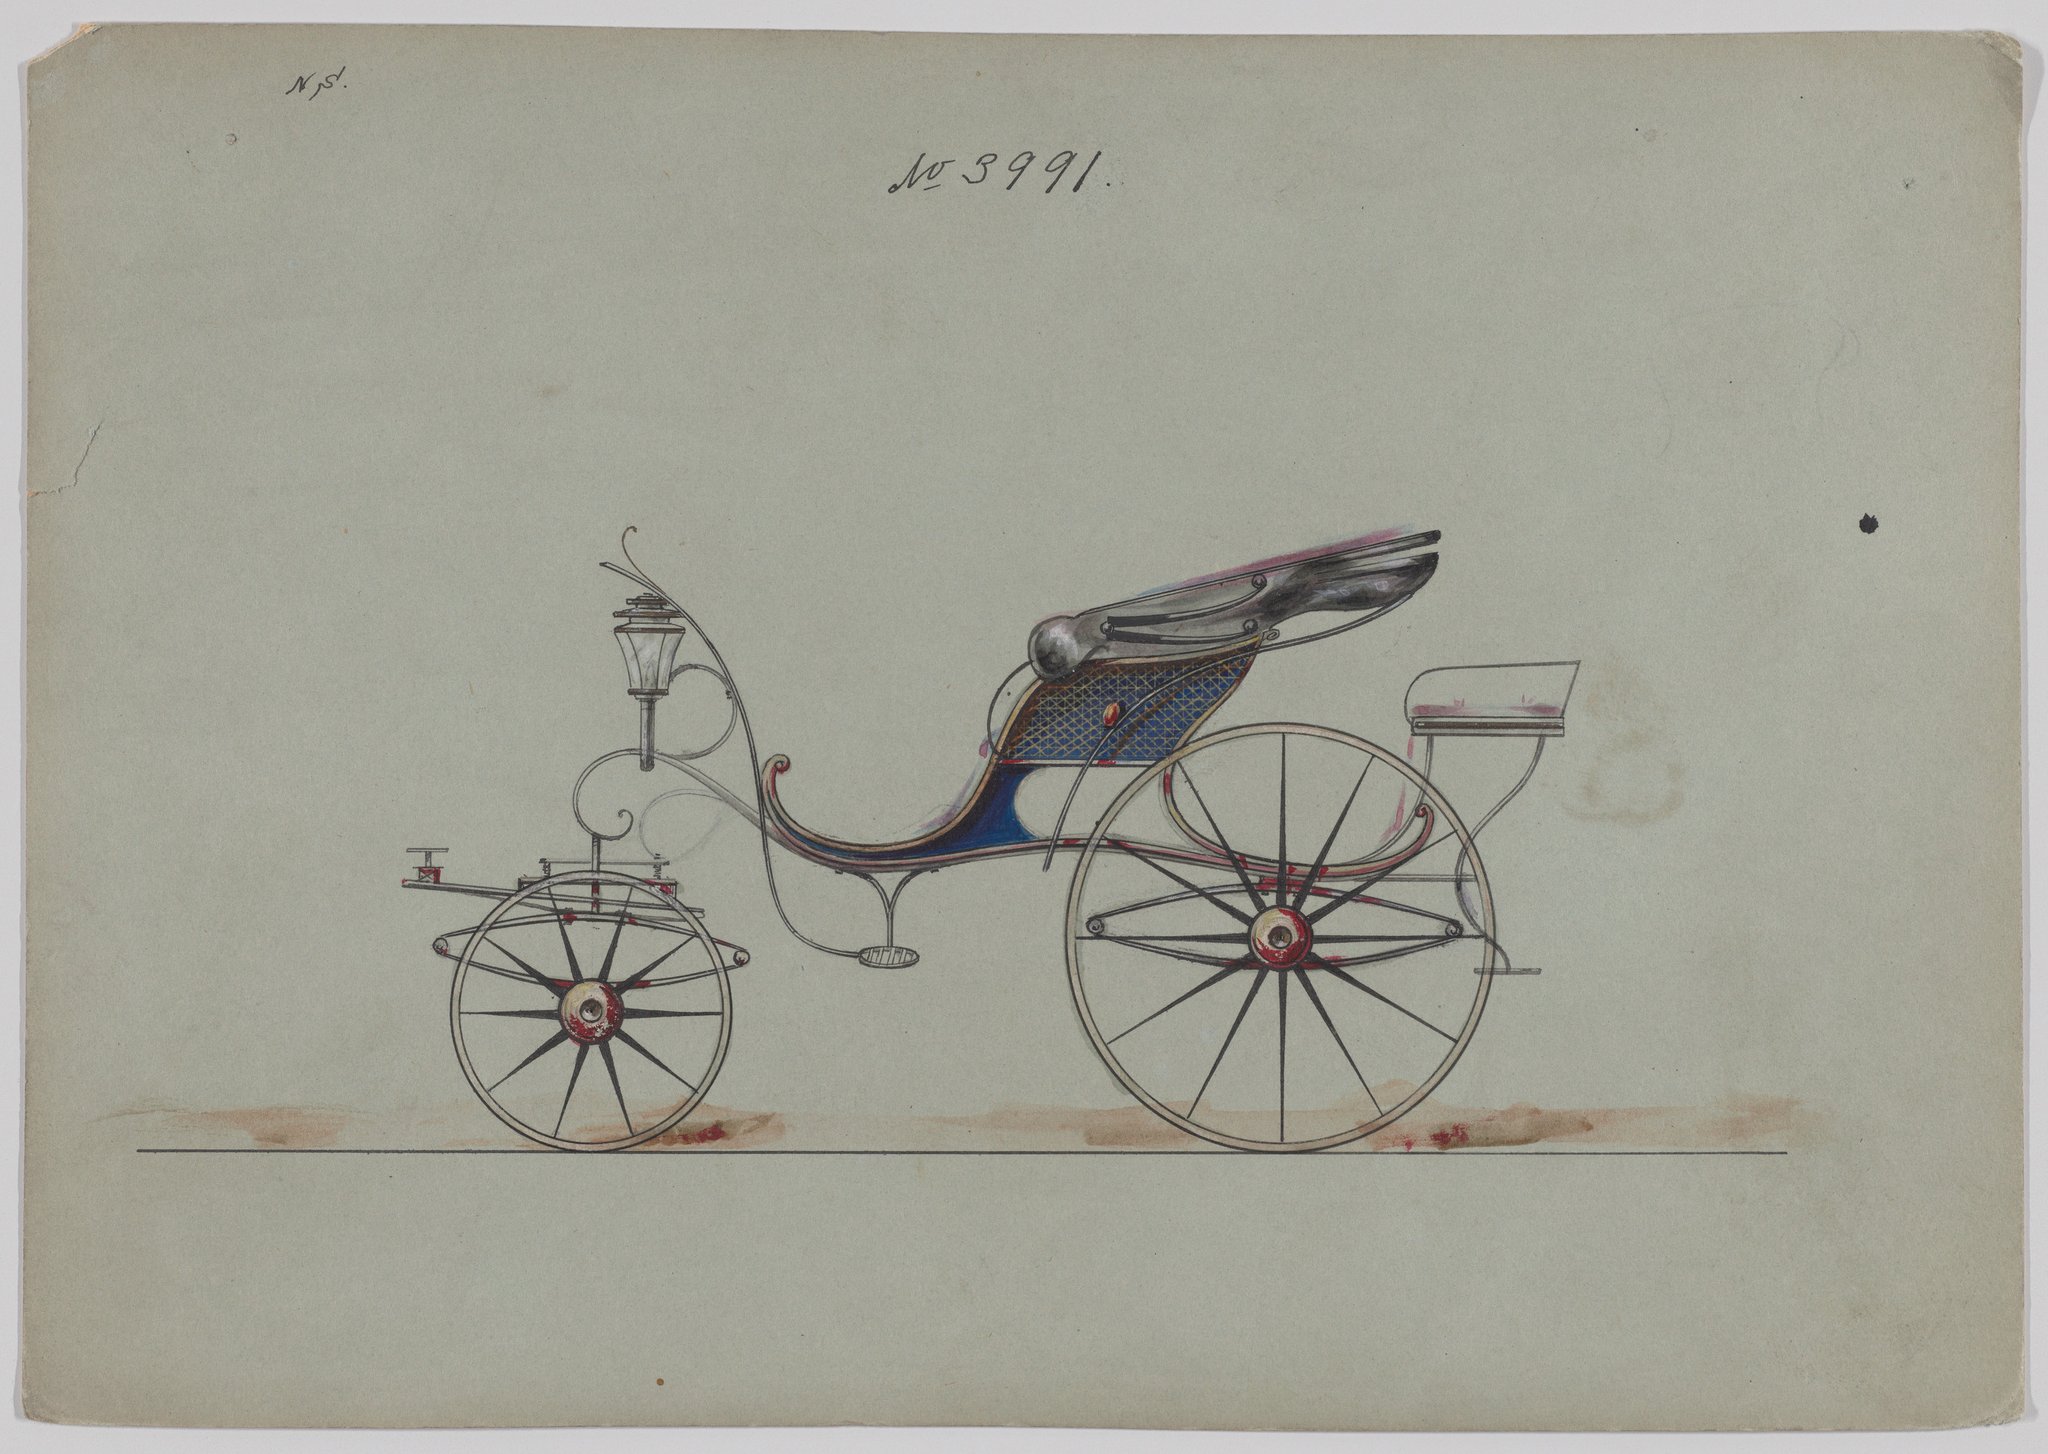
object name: drawing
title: Design for Pony Phaeton, no. 3991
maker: brewster & co.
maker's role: manufacturer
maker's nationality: american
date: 1887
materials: gouache, gum arabic, ink, watercolor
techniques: pen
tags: carriages